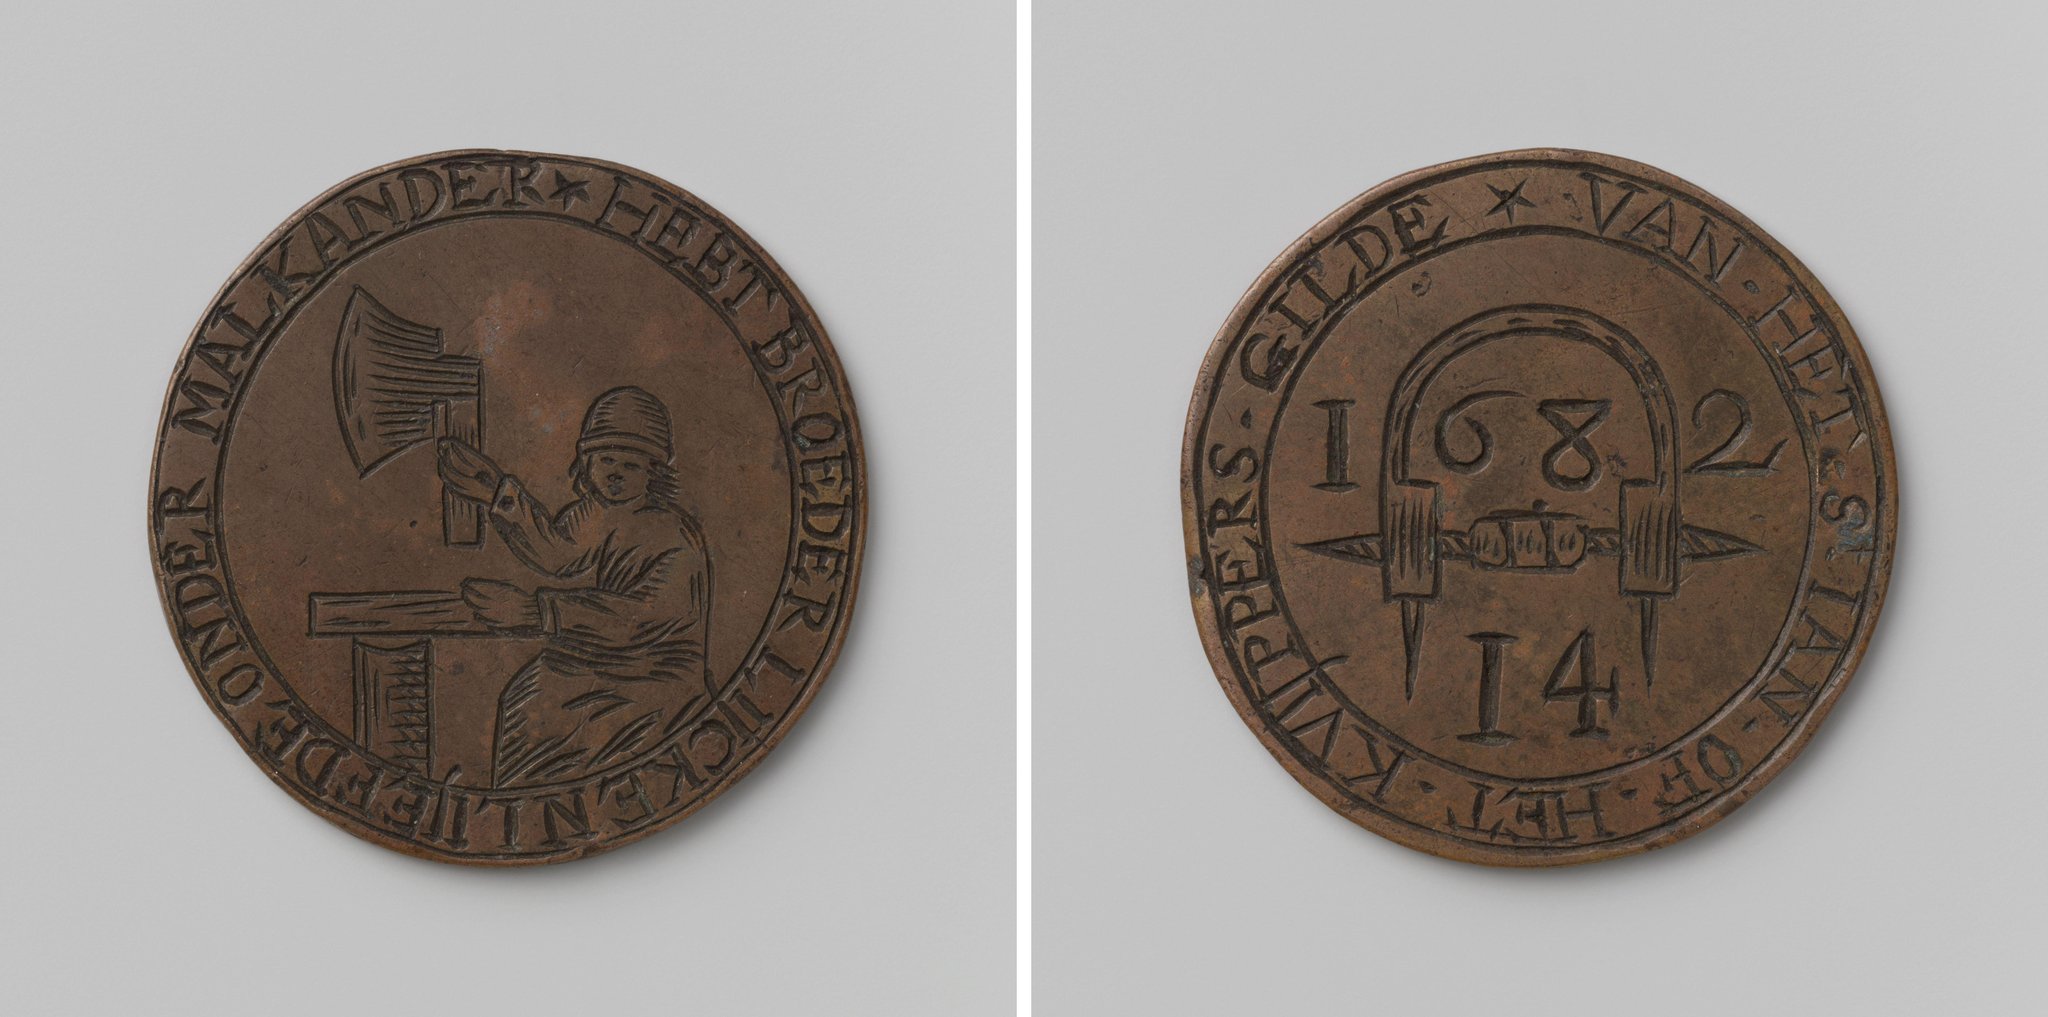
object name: medal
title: Kuipersgilde van Delft, gildepenning met no. 14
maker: Anonymous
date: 1682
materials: copper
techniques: engraving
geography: delft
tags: delft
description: Koperen penning. Voorzijde: zittende kuiper met grote bijl in geheven rechterhand binnen omschrift. Keerzijde: dissel en passer; daartussen jaartal boven cijfer 14 binnen omschrift